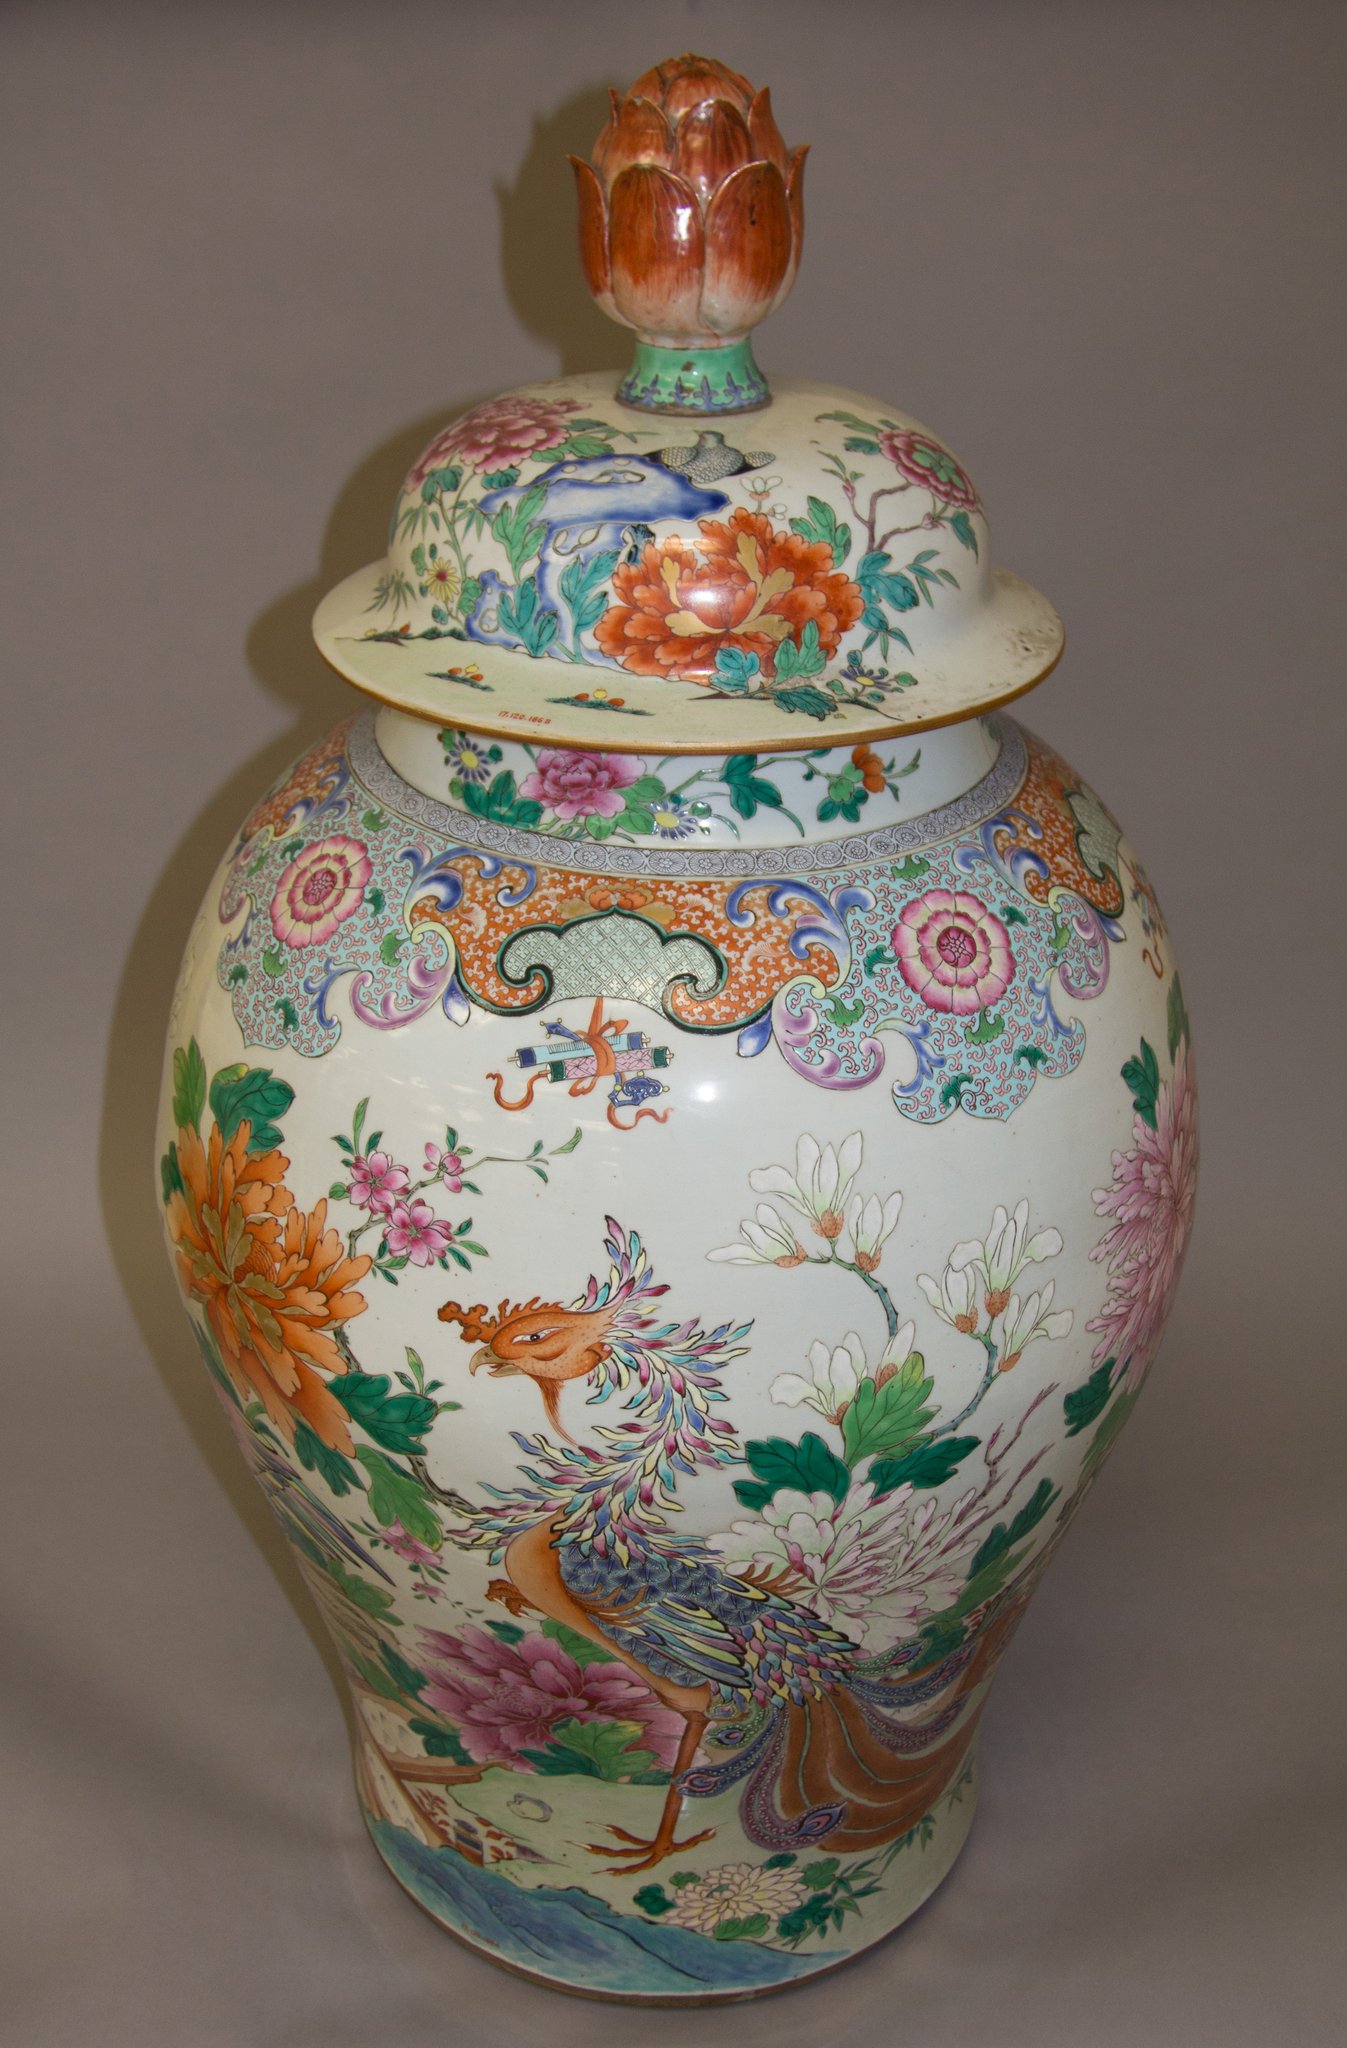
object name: covered jar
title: Covered jar with phoenix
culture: chinese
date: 1767-1800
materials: enamel, porcelain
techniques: overglaze, painting, polychrome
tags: birds,flowers,leaves